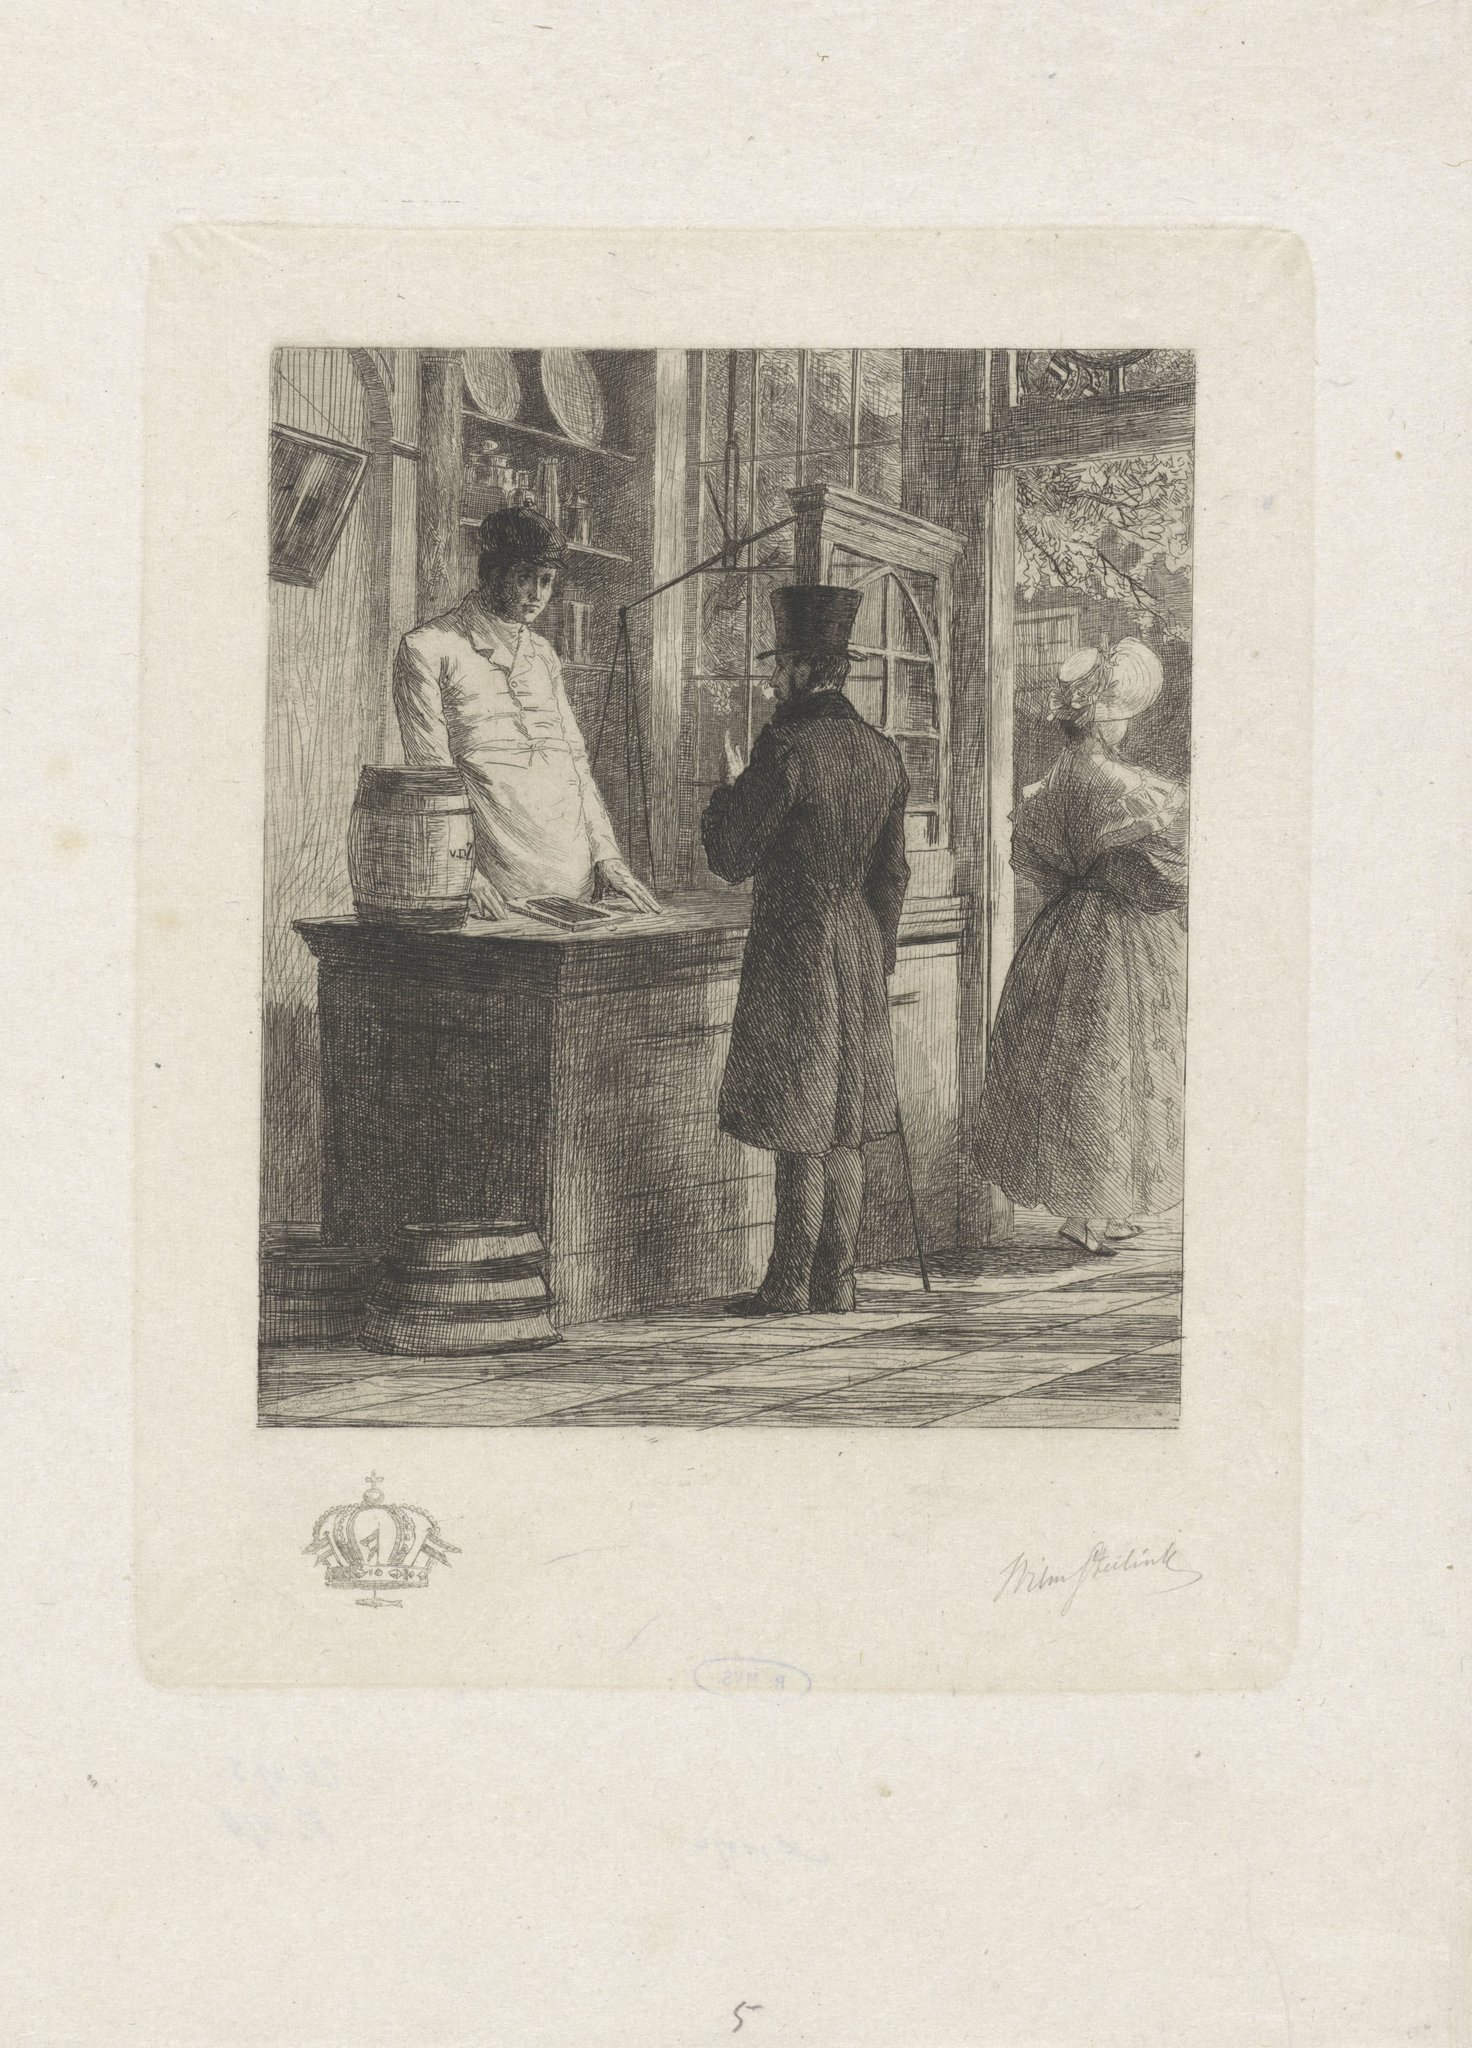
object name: print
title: Interieur van een winkel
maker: willem steelink (ii)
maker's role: draughtsman, print maker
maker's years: 1856-1928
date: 1866-1886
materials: paper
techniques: etching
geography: netherlands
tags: shop, store, counter ~ shop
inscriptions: collector's mark: Lugt 2228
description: Een man met hoge hoed spreekt met een kruidenier, die achter zijn toonbank staat. Een vrouw verlaat de winkel. Linksonder in de marge een kroon, vlaggen en een vis.